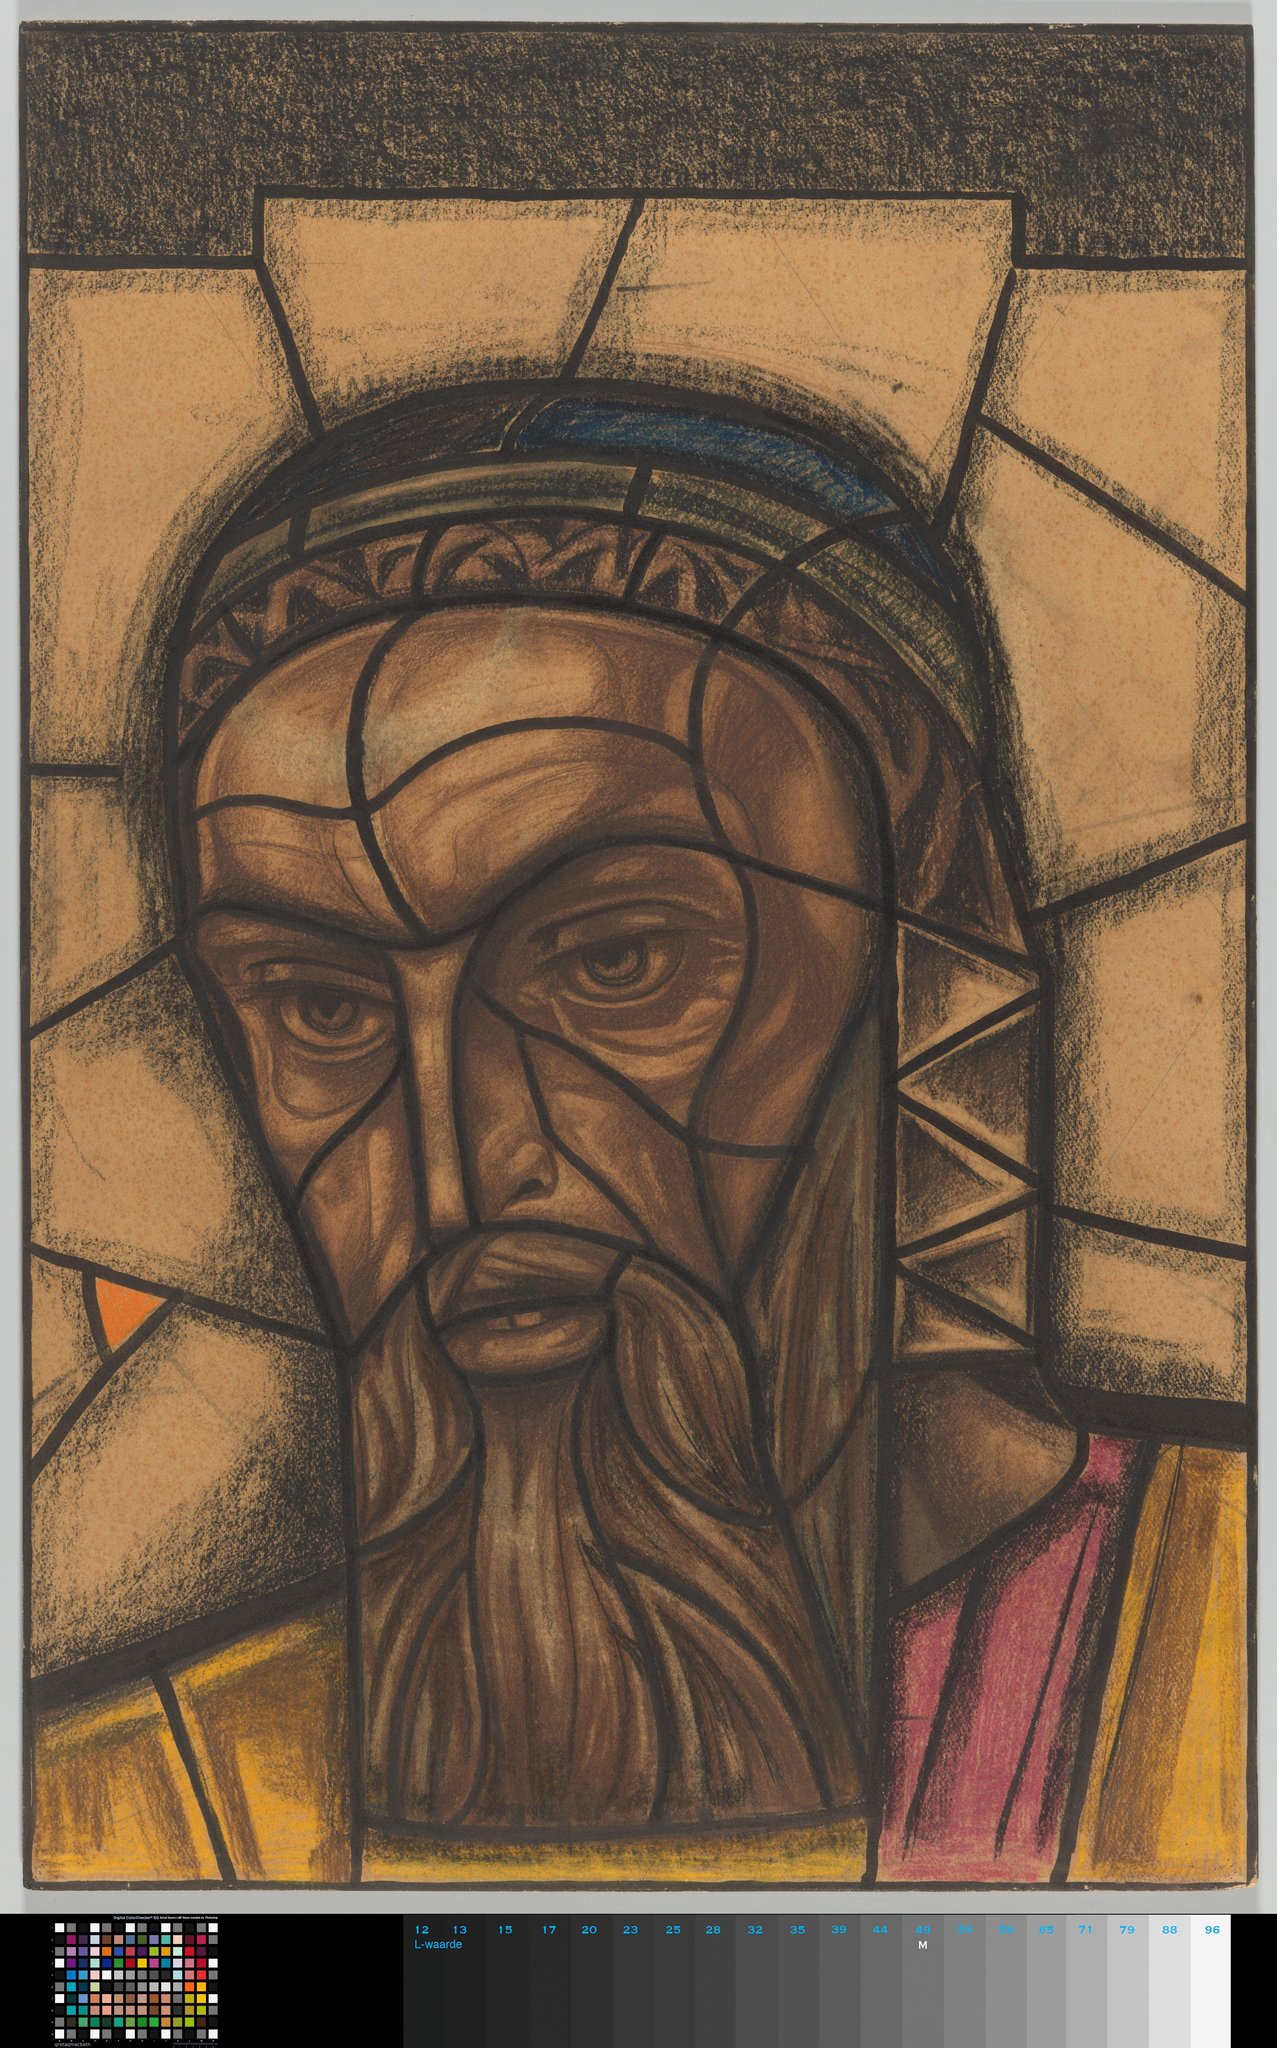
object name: design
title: Ontwerp voor raam in het Zuidertransept van de Dom te Utrecht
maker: richard nicolaüs roland holst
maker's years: 1868-1938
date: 1878-1938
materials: cardboard, chalk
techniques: brush